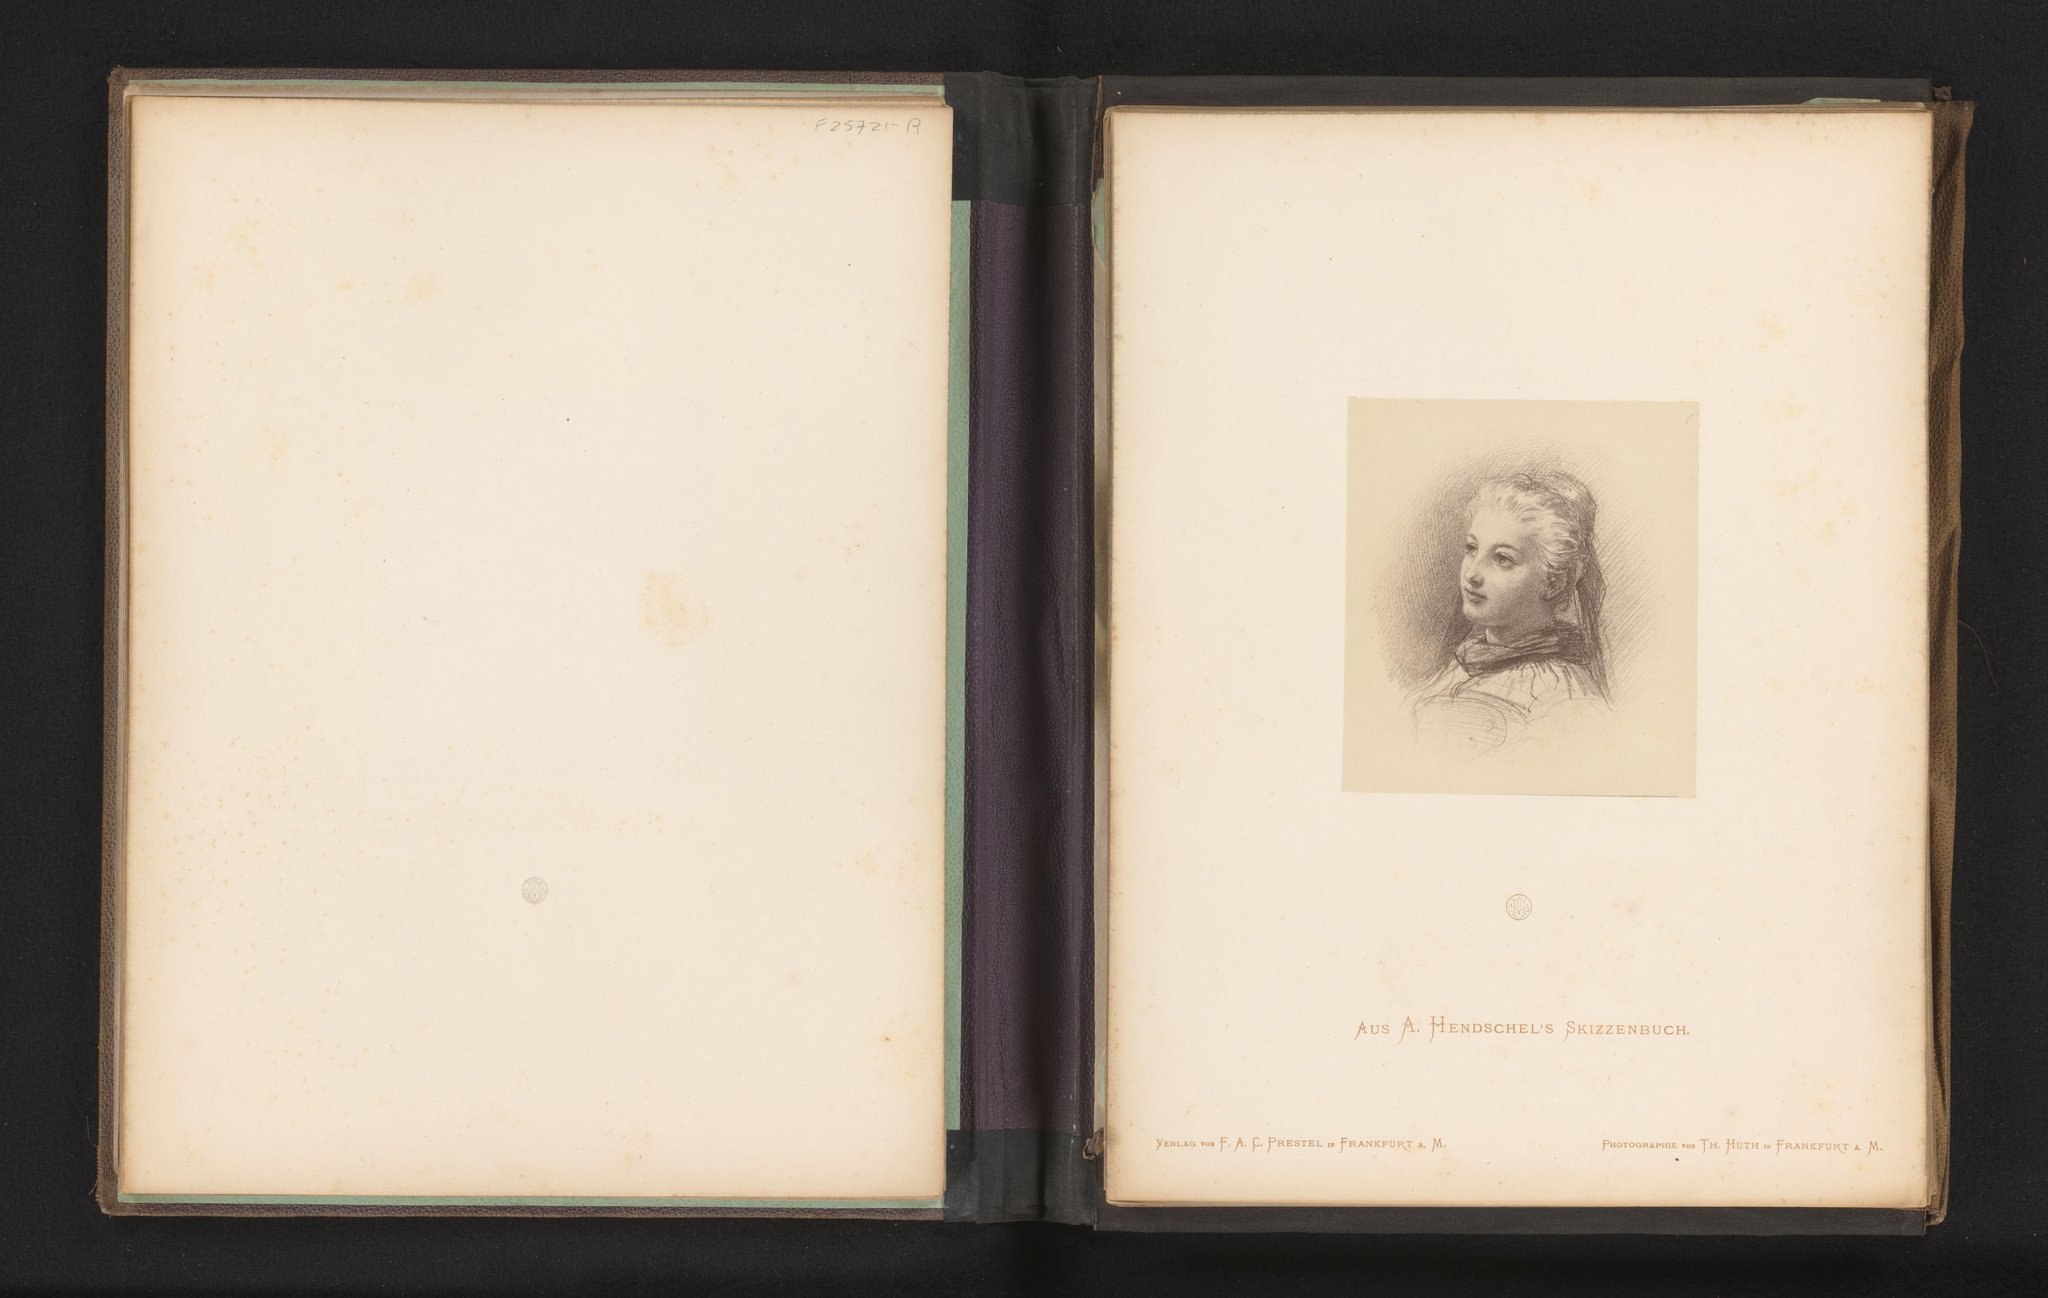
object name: reproduction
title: Fotoreproductie van een schets van een portret van een onbekende vrouw uit Oberhessen, door Albert Hendschel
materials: paper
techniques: albumen print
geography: frankfurt am main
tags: historical persons not known by name - bb - woman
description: Deze foto maakt deel uit van een omslag met 50 foto's op 48 bladen, een lijst van afbeeldingen en een titelblad.